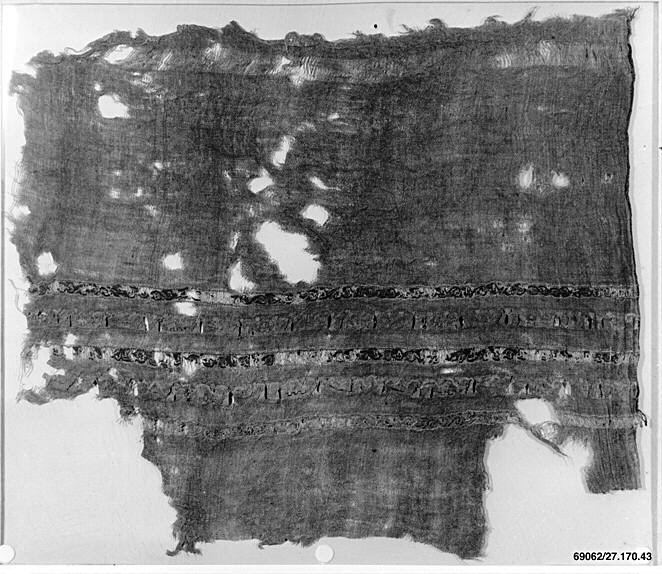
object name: textile fragment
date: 1101-1200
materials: linen, silk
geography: egypt